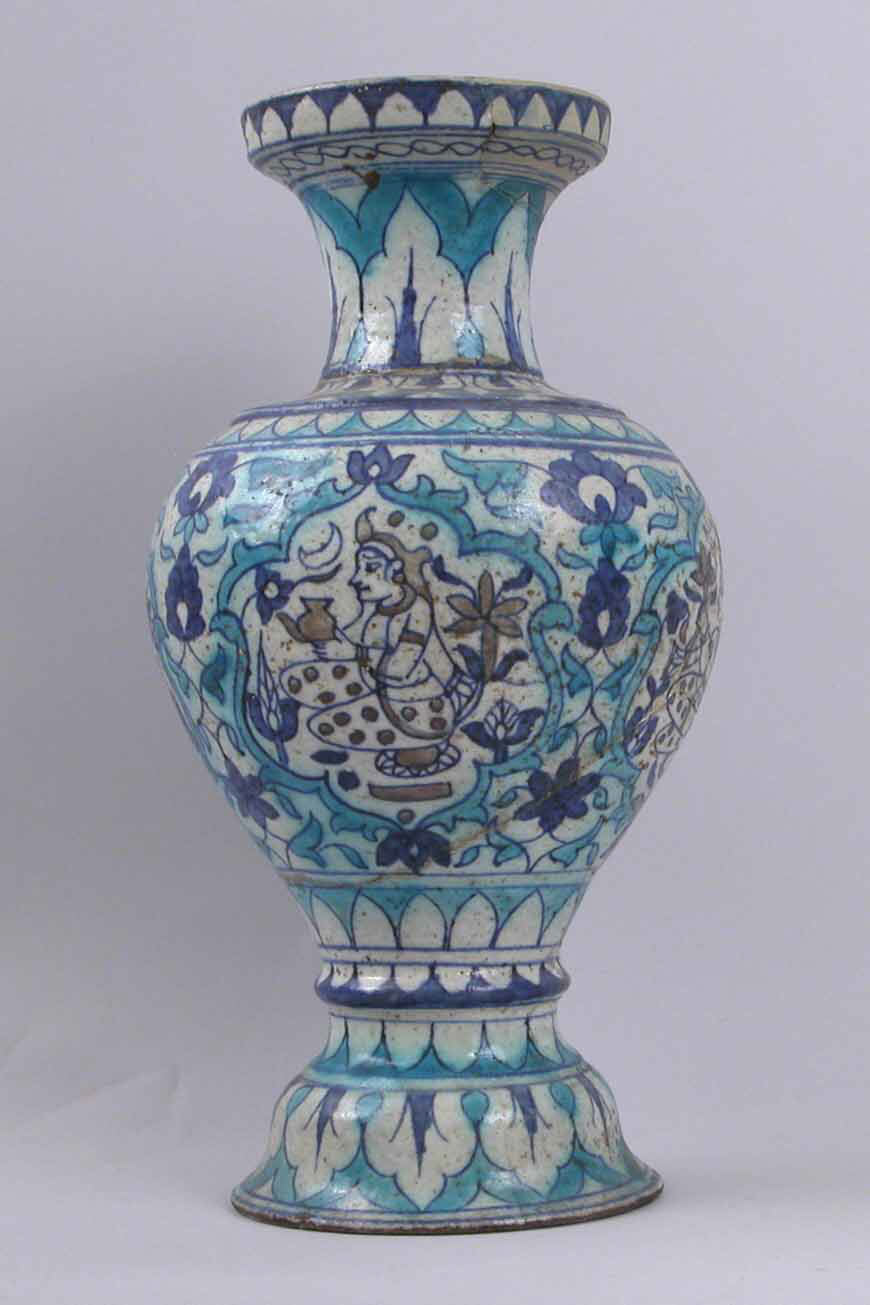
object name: vase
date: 1601-1800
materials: earthenware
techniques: glazing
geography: india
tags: human figures